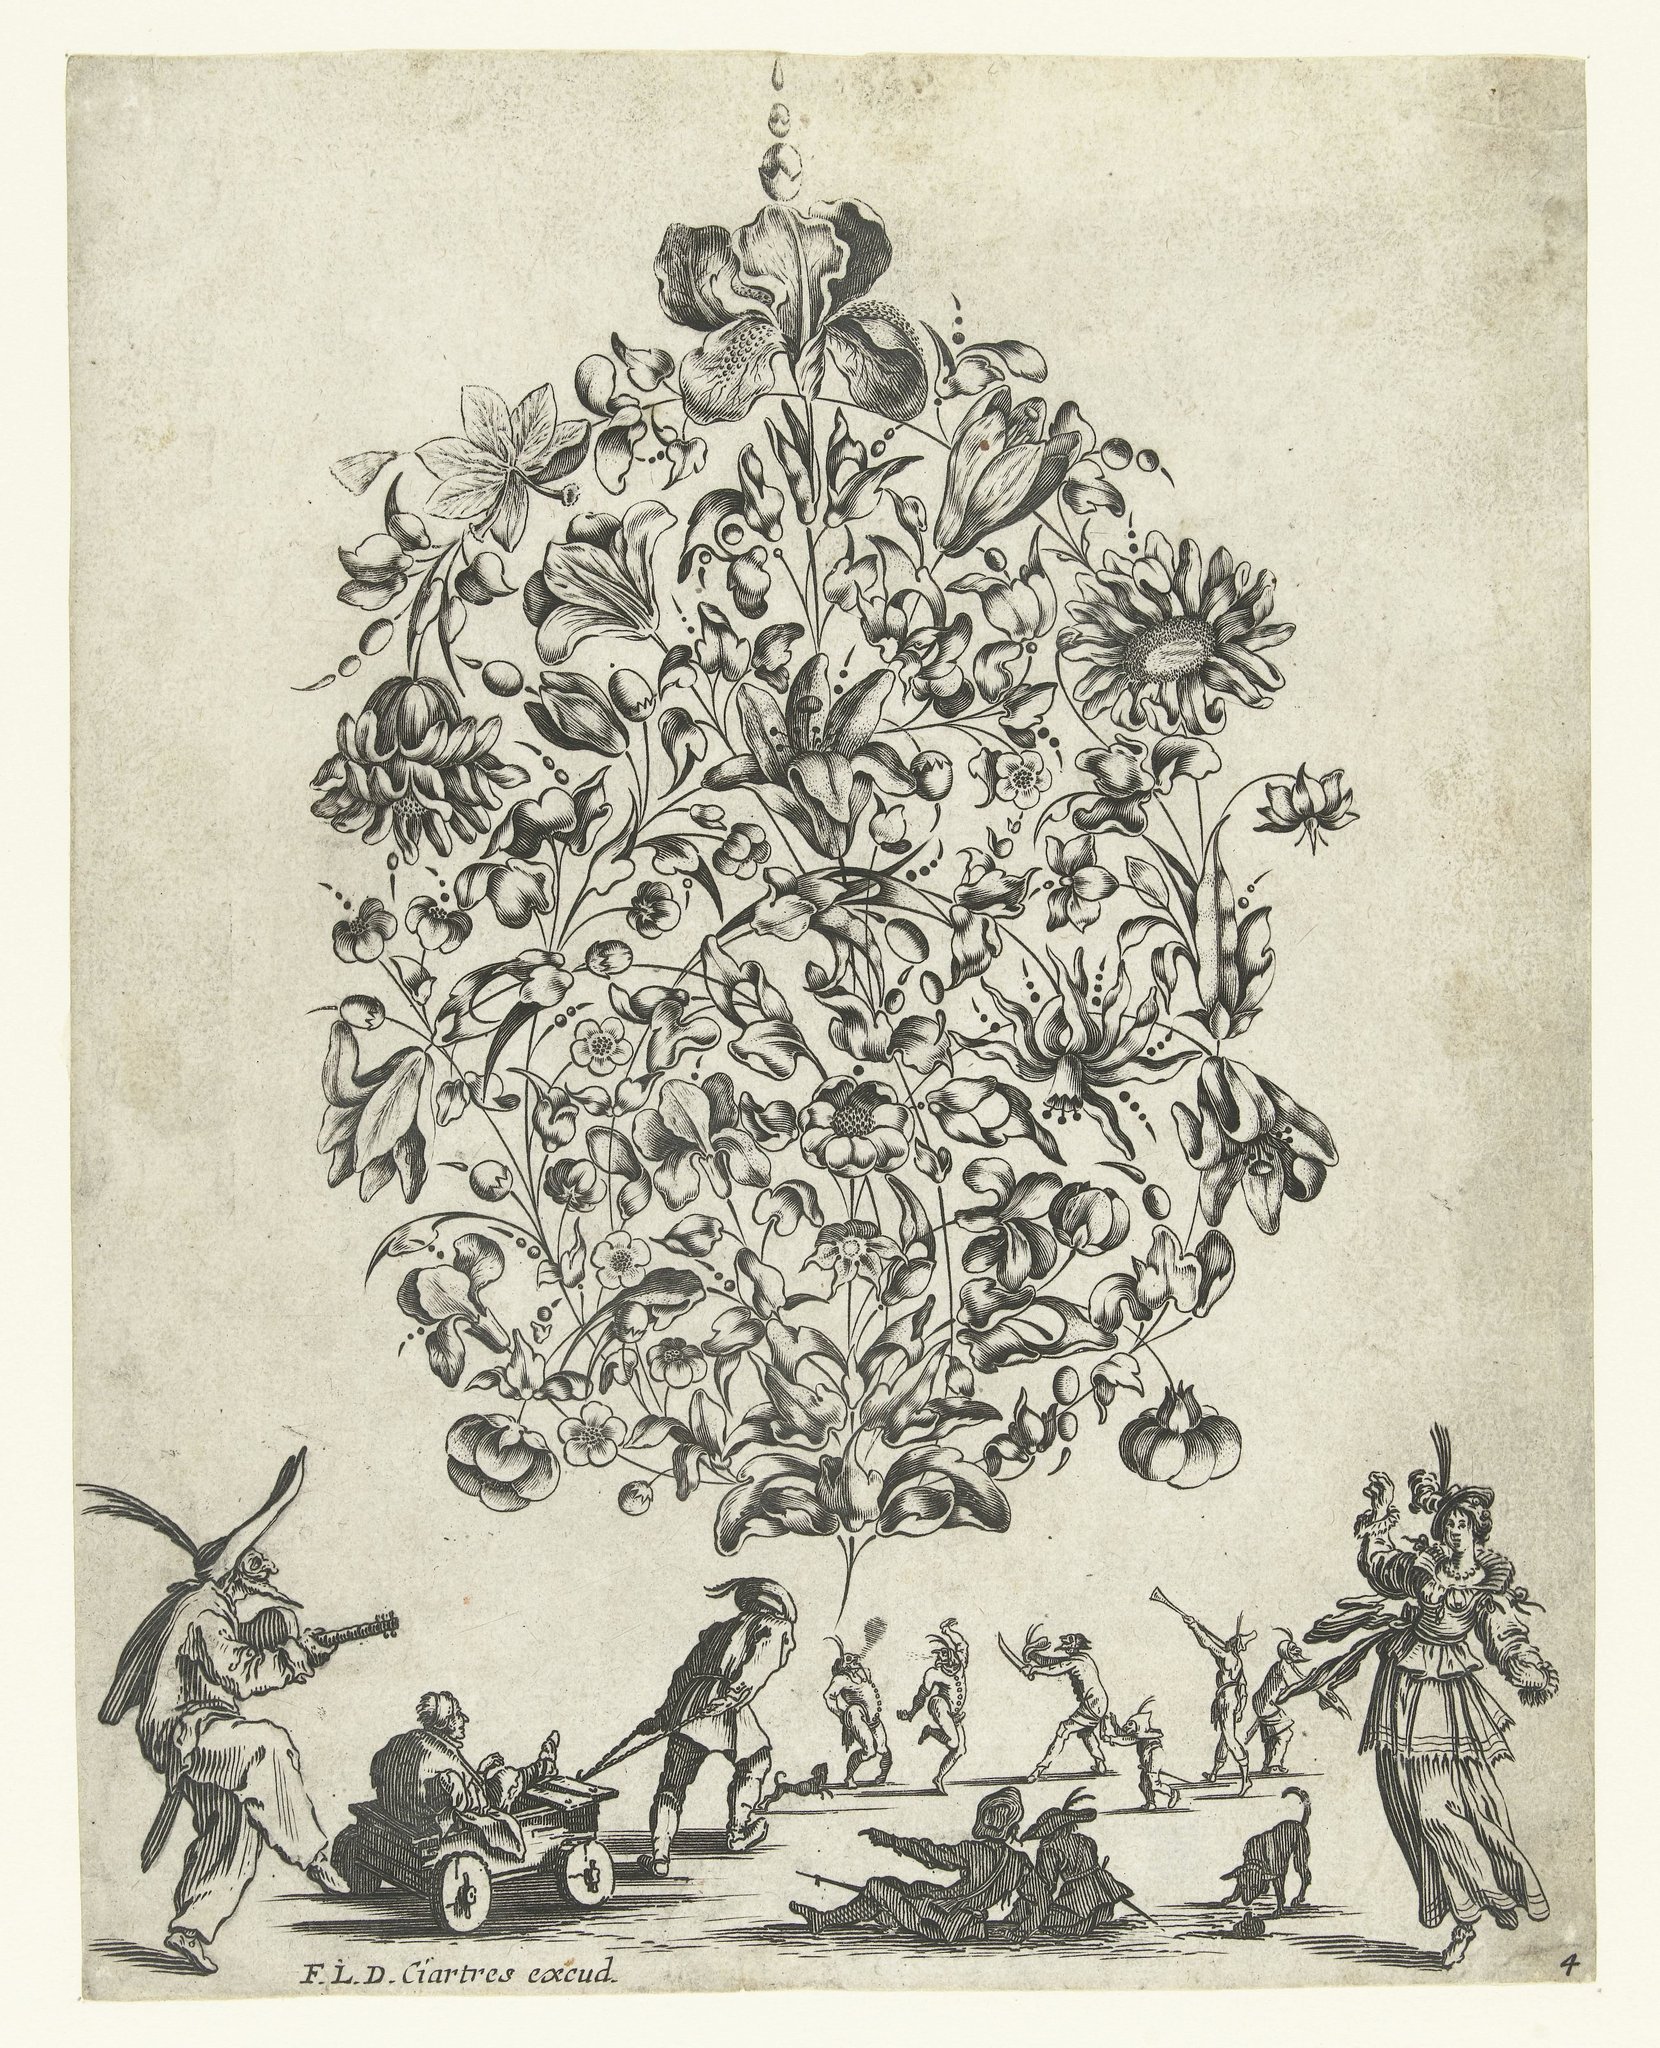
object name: print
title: Livre de Fleurs & de Feullies pour servir a l'art d'orfeveri (...)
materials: paper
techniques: etching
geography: france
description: Met midden boven een iris en onderaan een aantal figuren naar Jacques Callot. Blad 4 uit serie met 6 boeketten voor goud- en zilversmeden. Tweede editie.